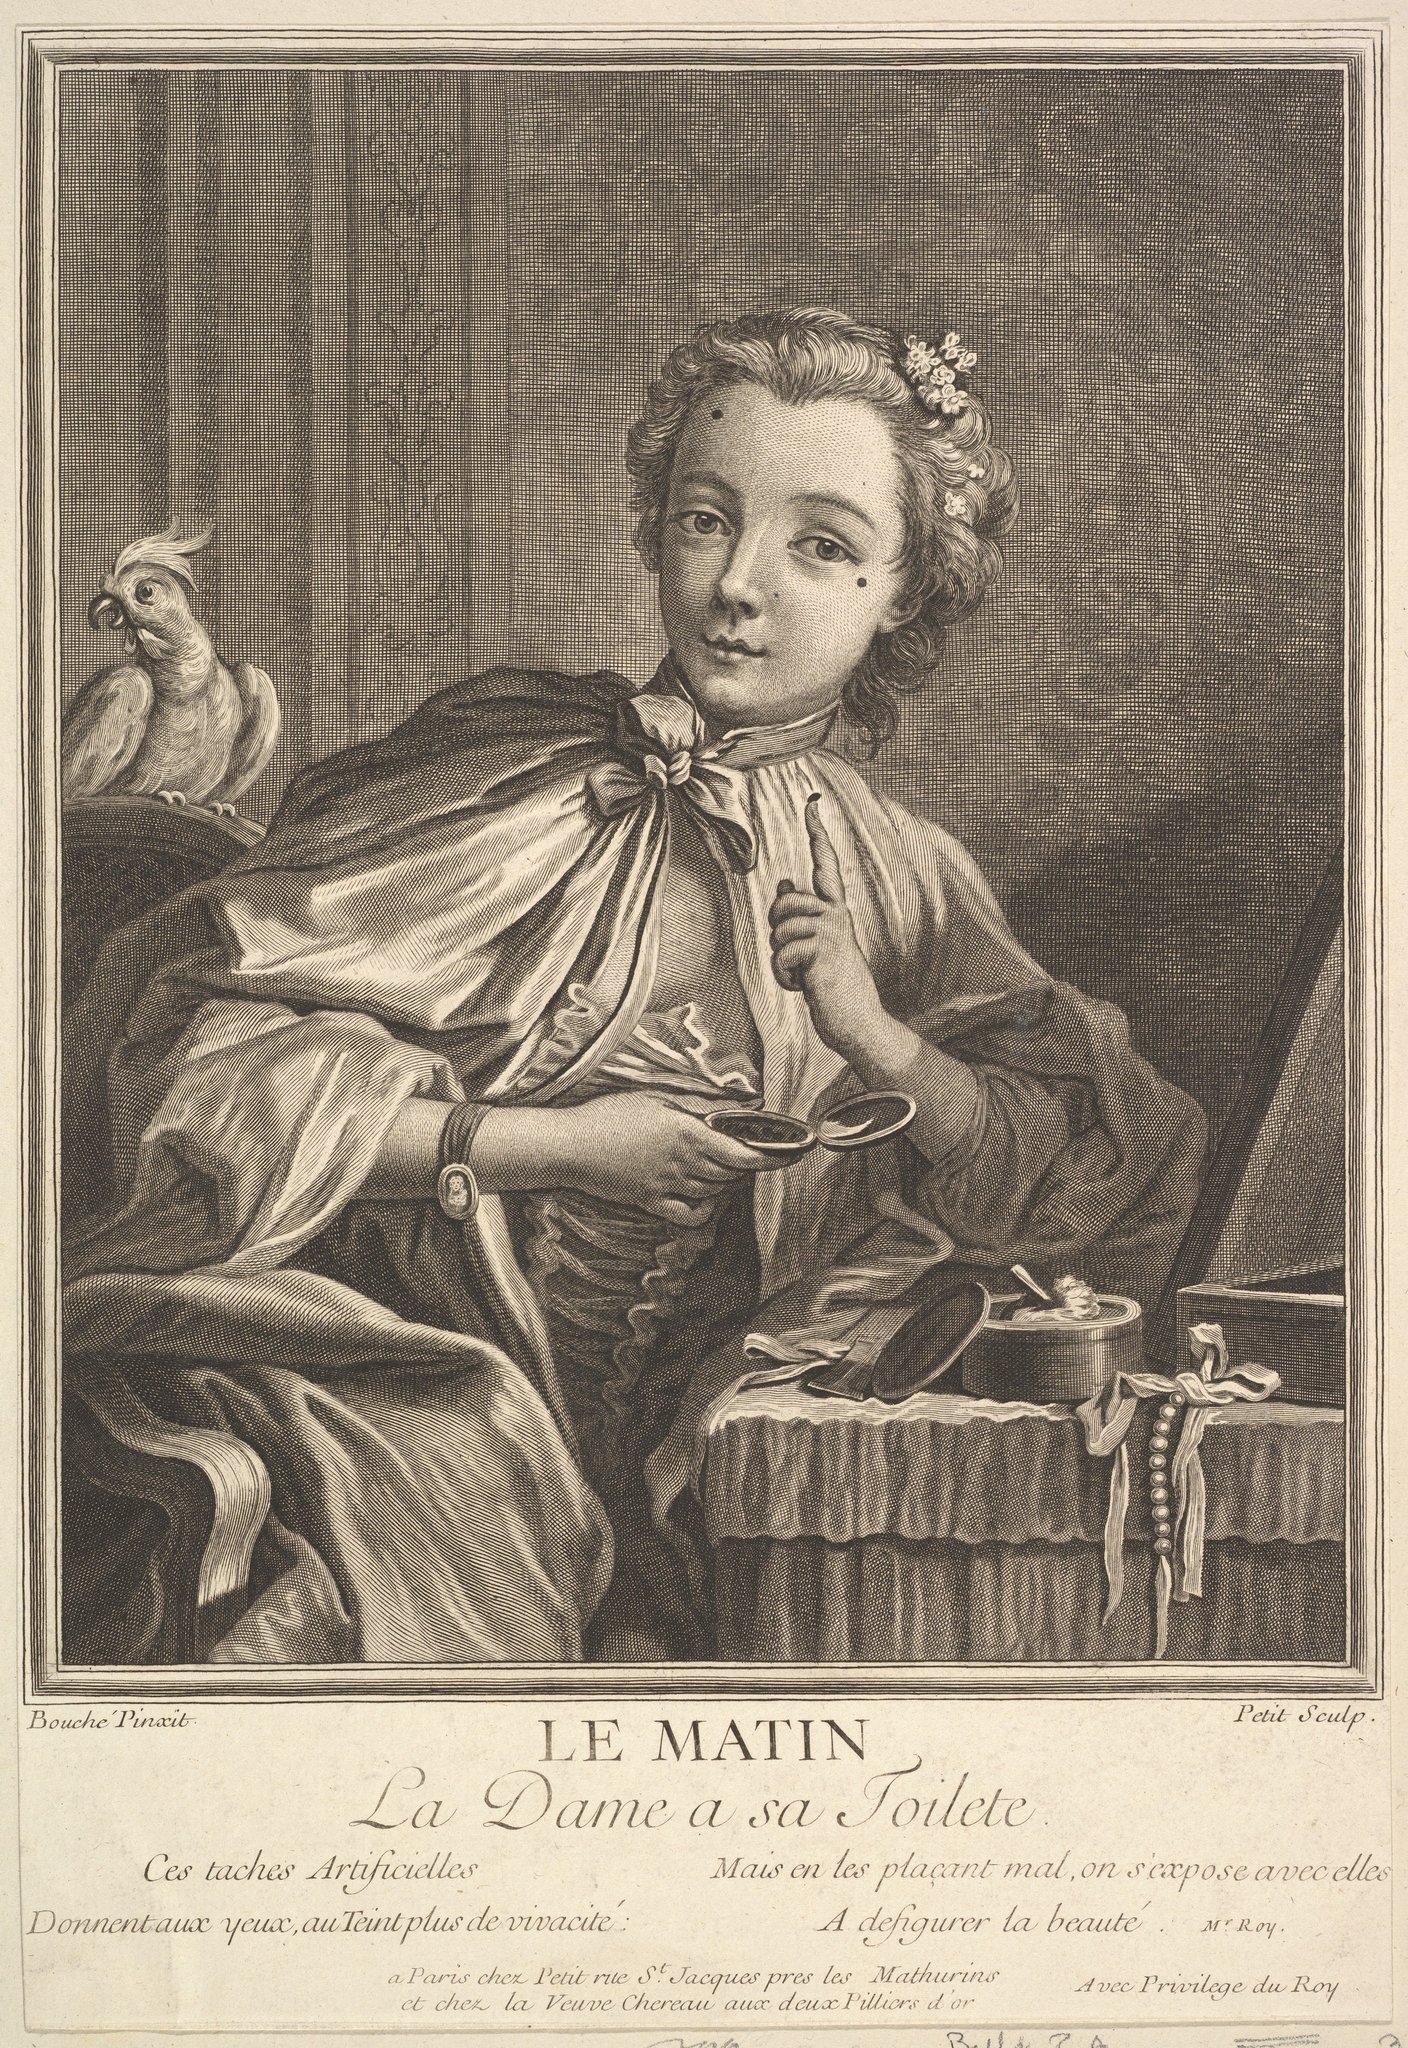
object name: print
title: Morning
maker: gilles edme petit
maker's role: artist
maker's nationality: french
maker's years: 1694-1760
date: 1694-1760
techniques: engraving, etching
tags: portraits,women,parrots